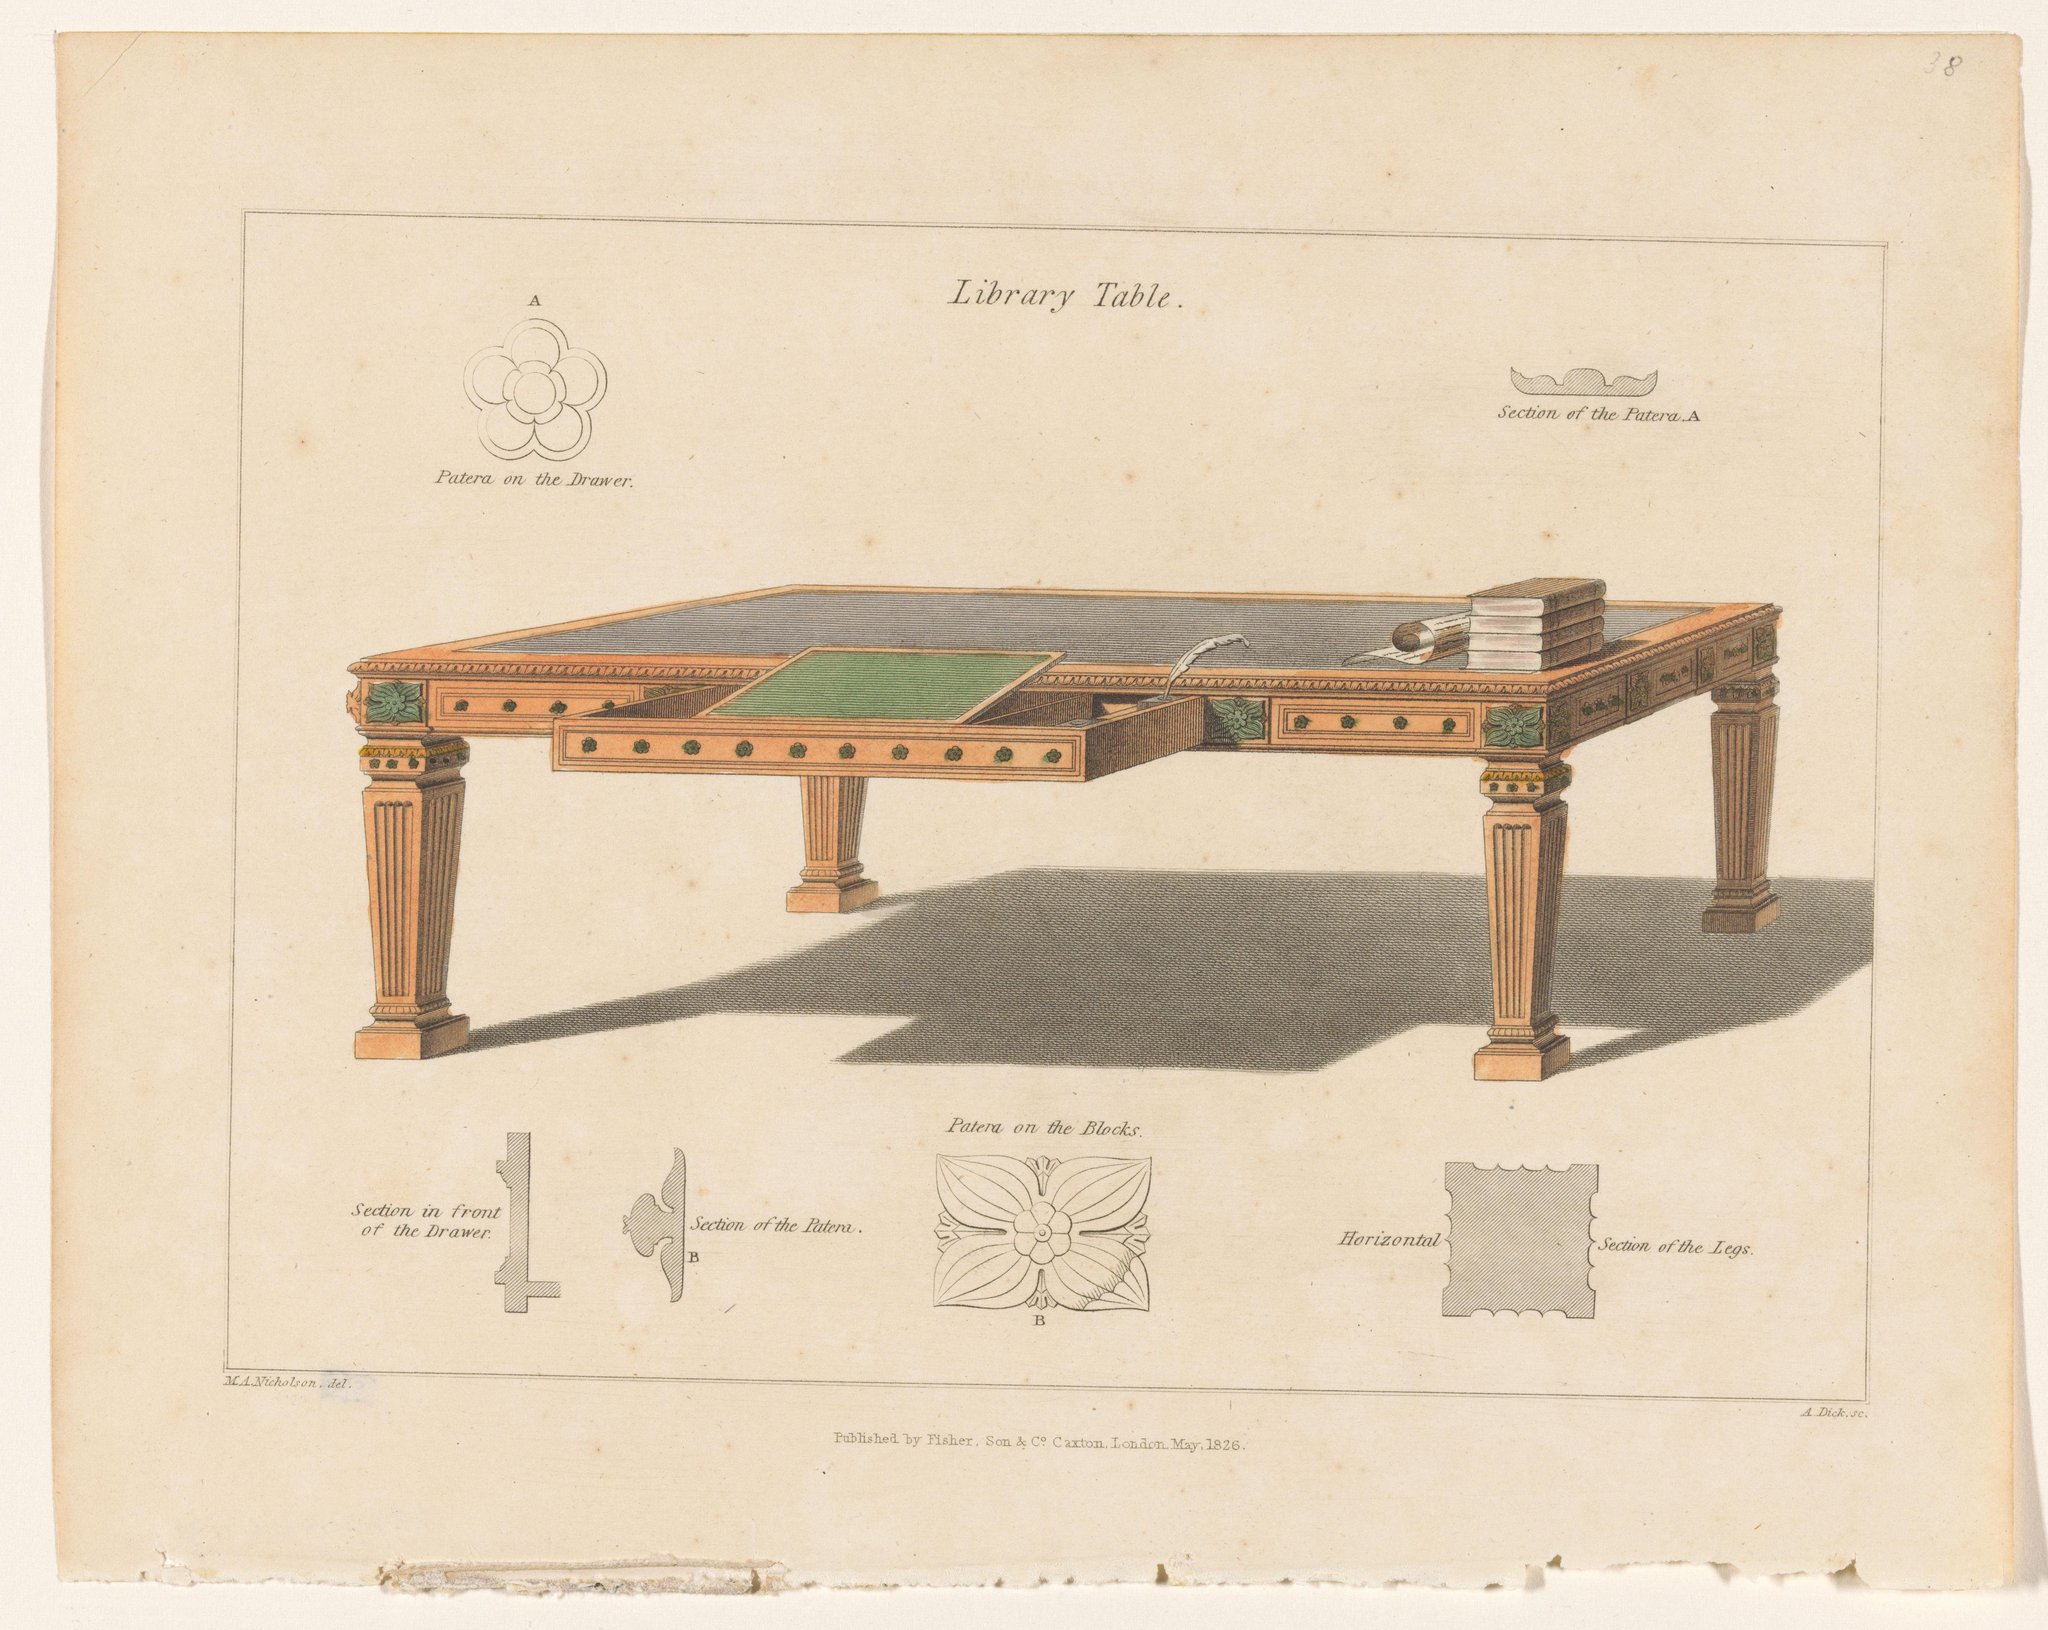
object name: book illustration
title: Library Table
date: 1805-1826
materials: paper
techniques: etching, hand coloring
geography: london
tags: writing-table, writing-desk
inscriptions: collector's mark: Lugt 2228, collector's mark: Lugt 4780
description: Prent waarschijnlijk afkomstig uit: Nicholson, Peter en Michael Angelo. The Practical Cabinet-Maker, Upholsterer and Complete Decorator. Londen: Fisher Son & Co., 1827.